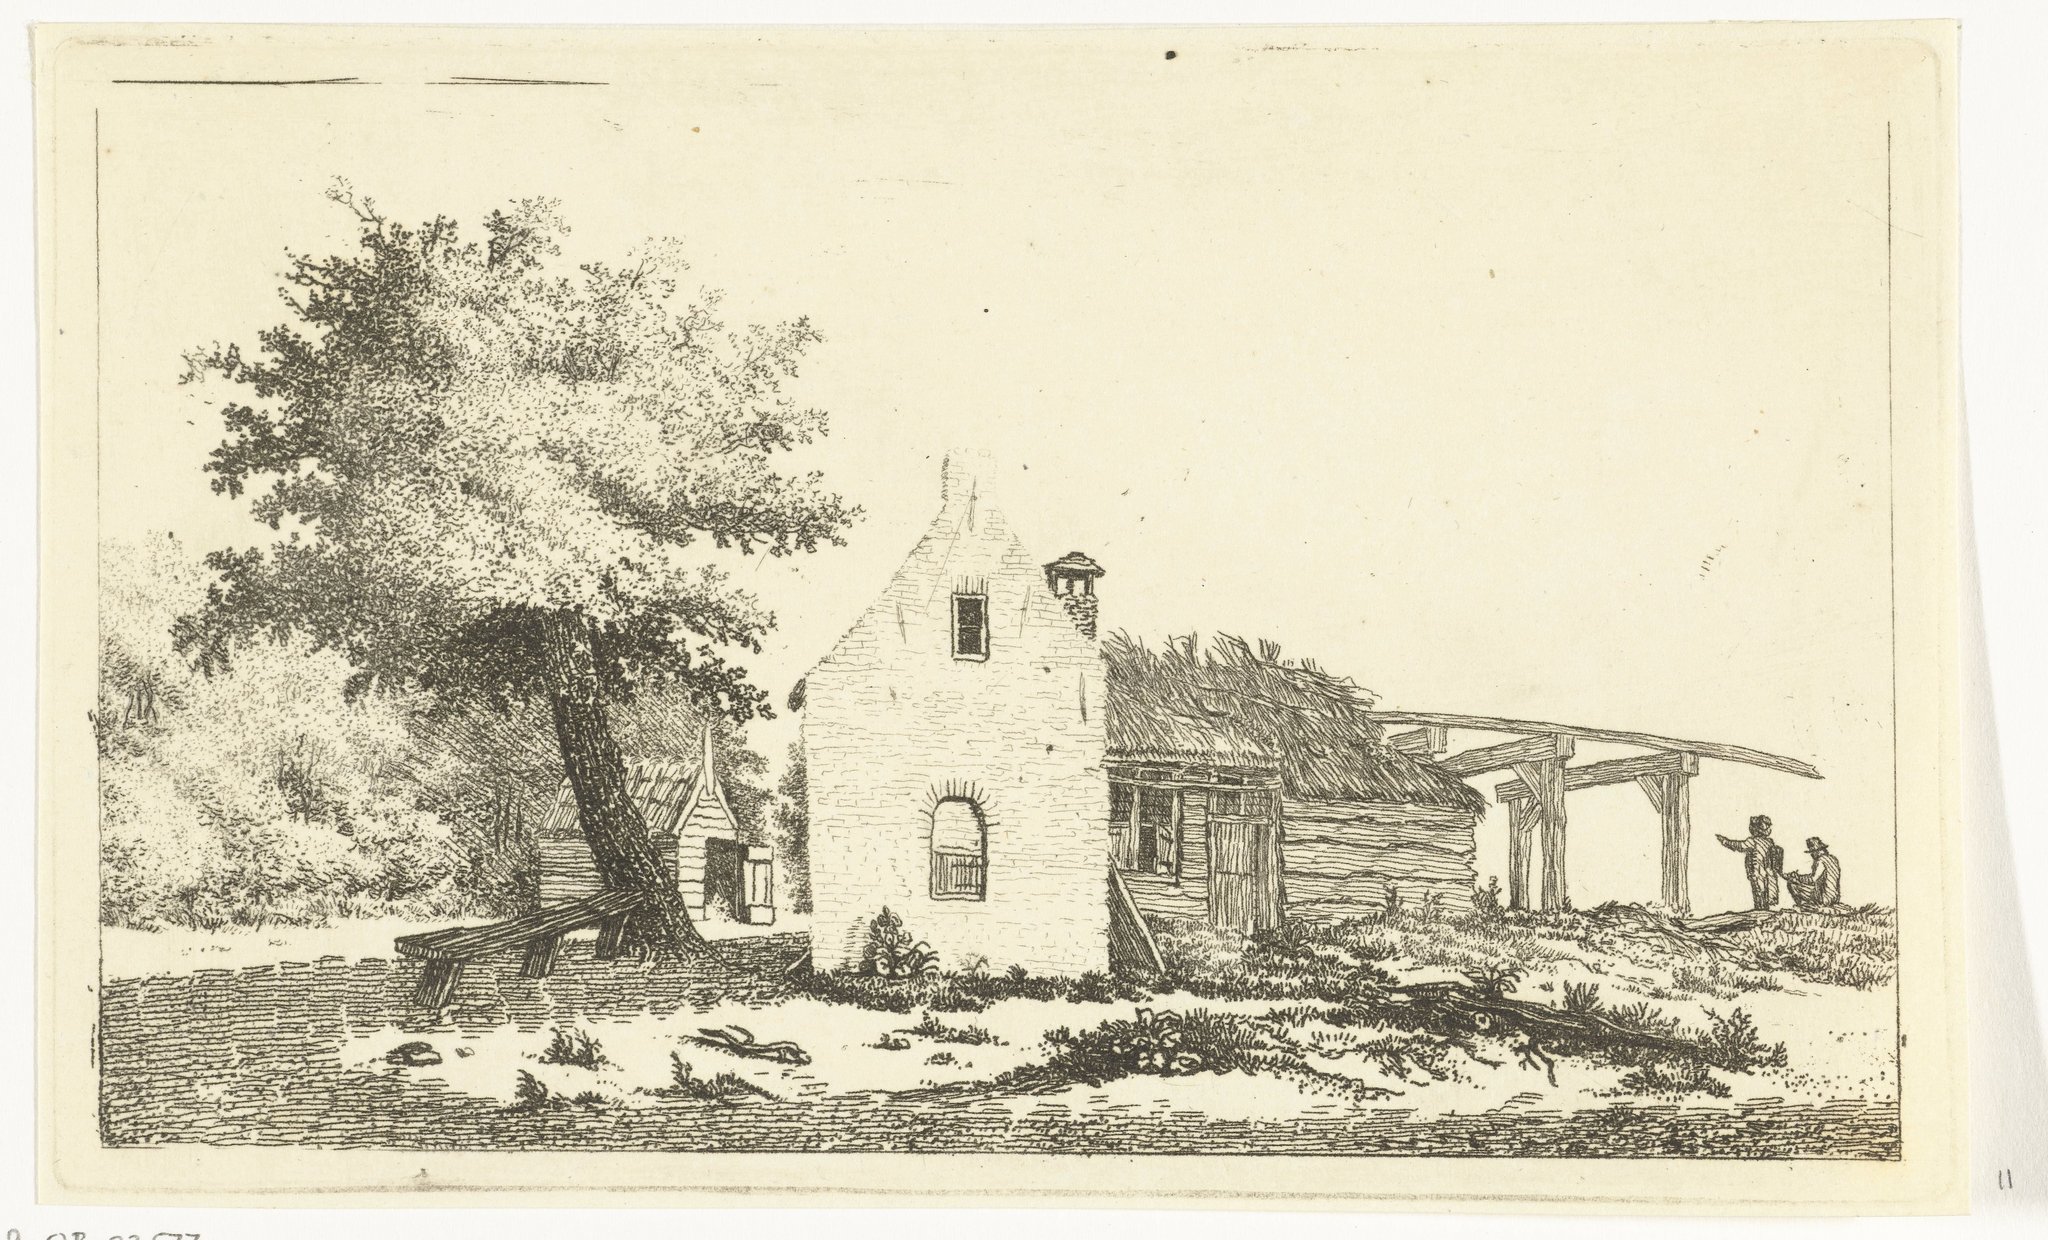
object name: print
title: Ruïne van herberg het Molentje aan de Amstel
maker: anthonie van den bos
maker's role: draughtsman, print maker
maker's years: 1763-1838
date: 1811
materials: paper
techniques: etching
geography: netherlands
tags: hotel, hostelry, inn, ruin of a dwelling, house, castle, etc.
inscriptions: collector's mark: Lugt 2228